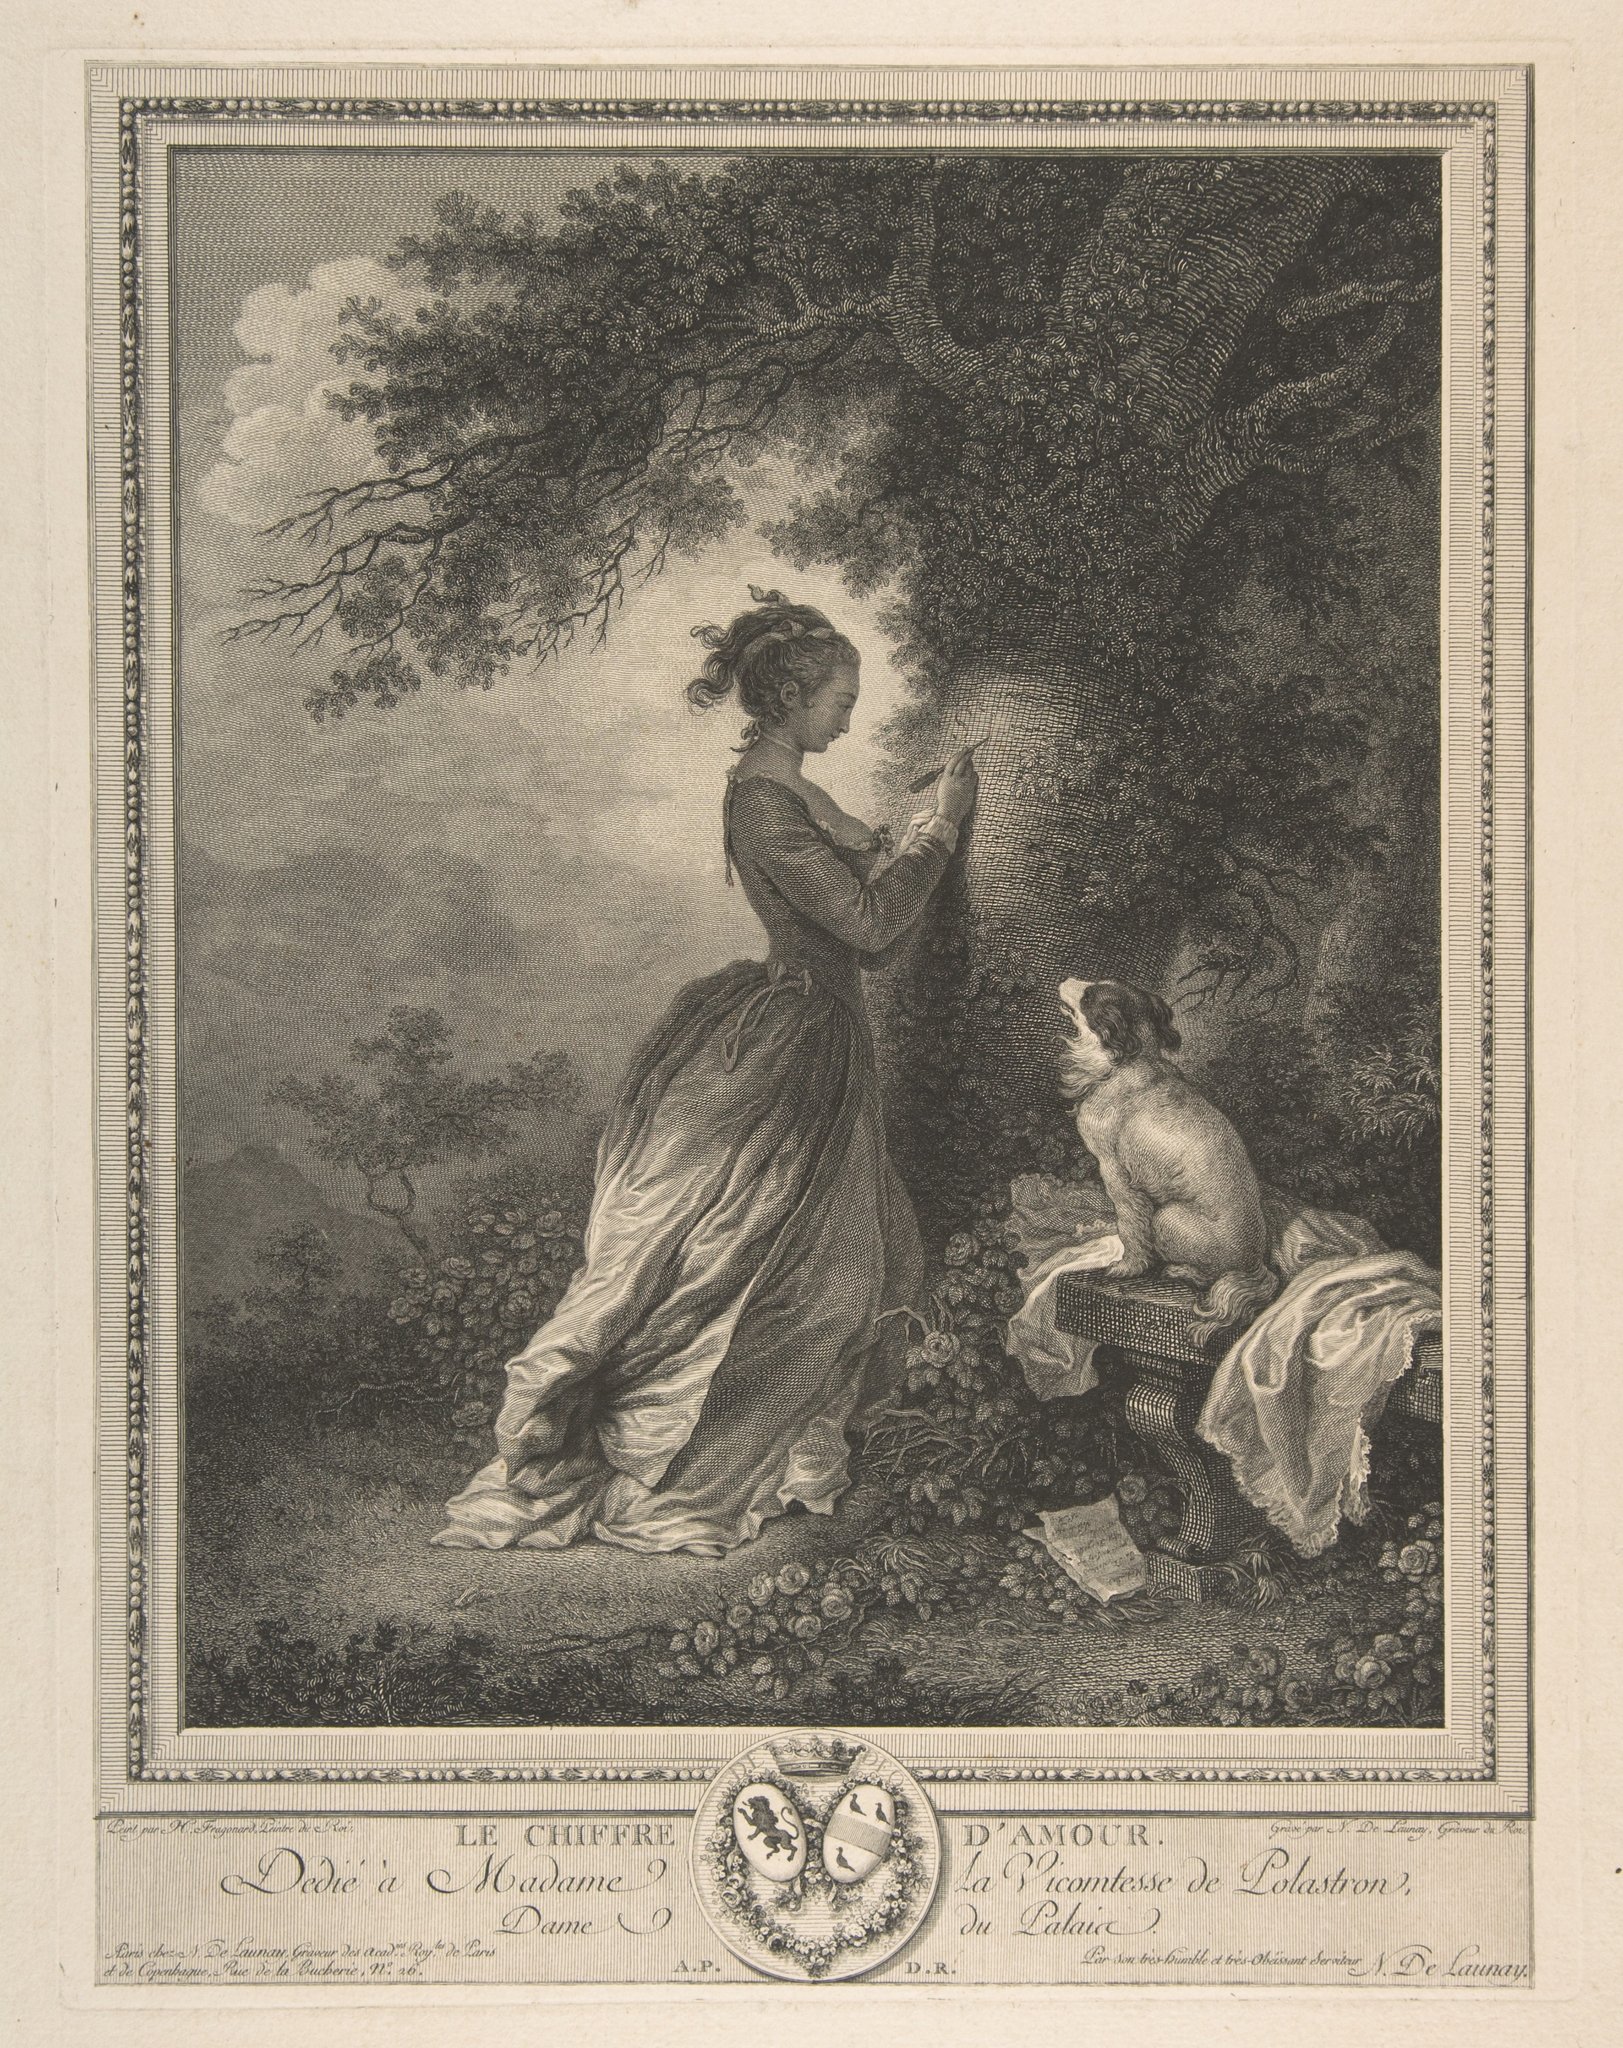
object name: print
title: Le Chiffre d'Amour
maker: jean honoré fragonard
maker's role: artist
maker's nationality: french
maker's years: 1732-1806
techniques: etching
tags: women,dogs,trees